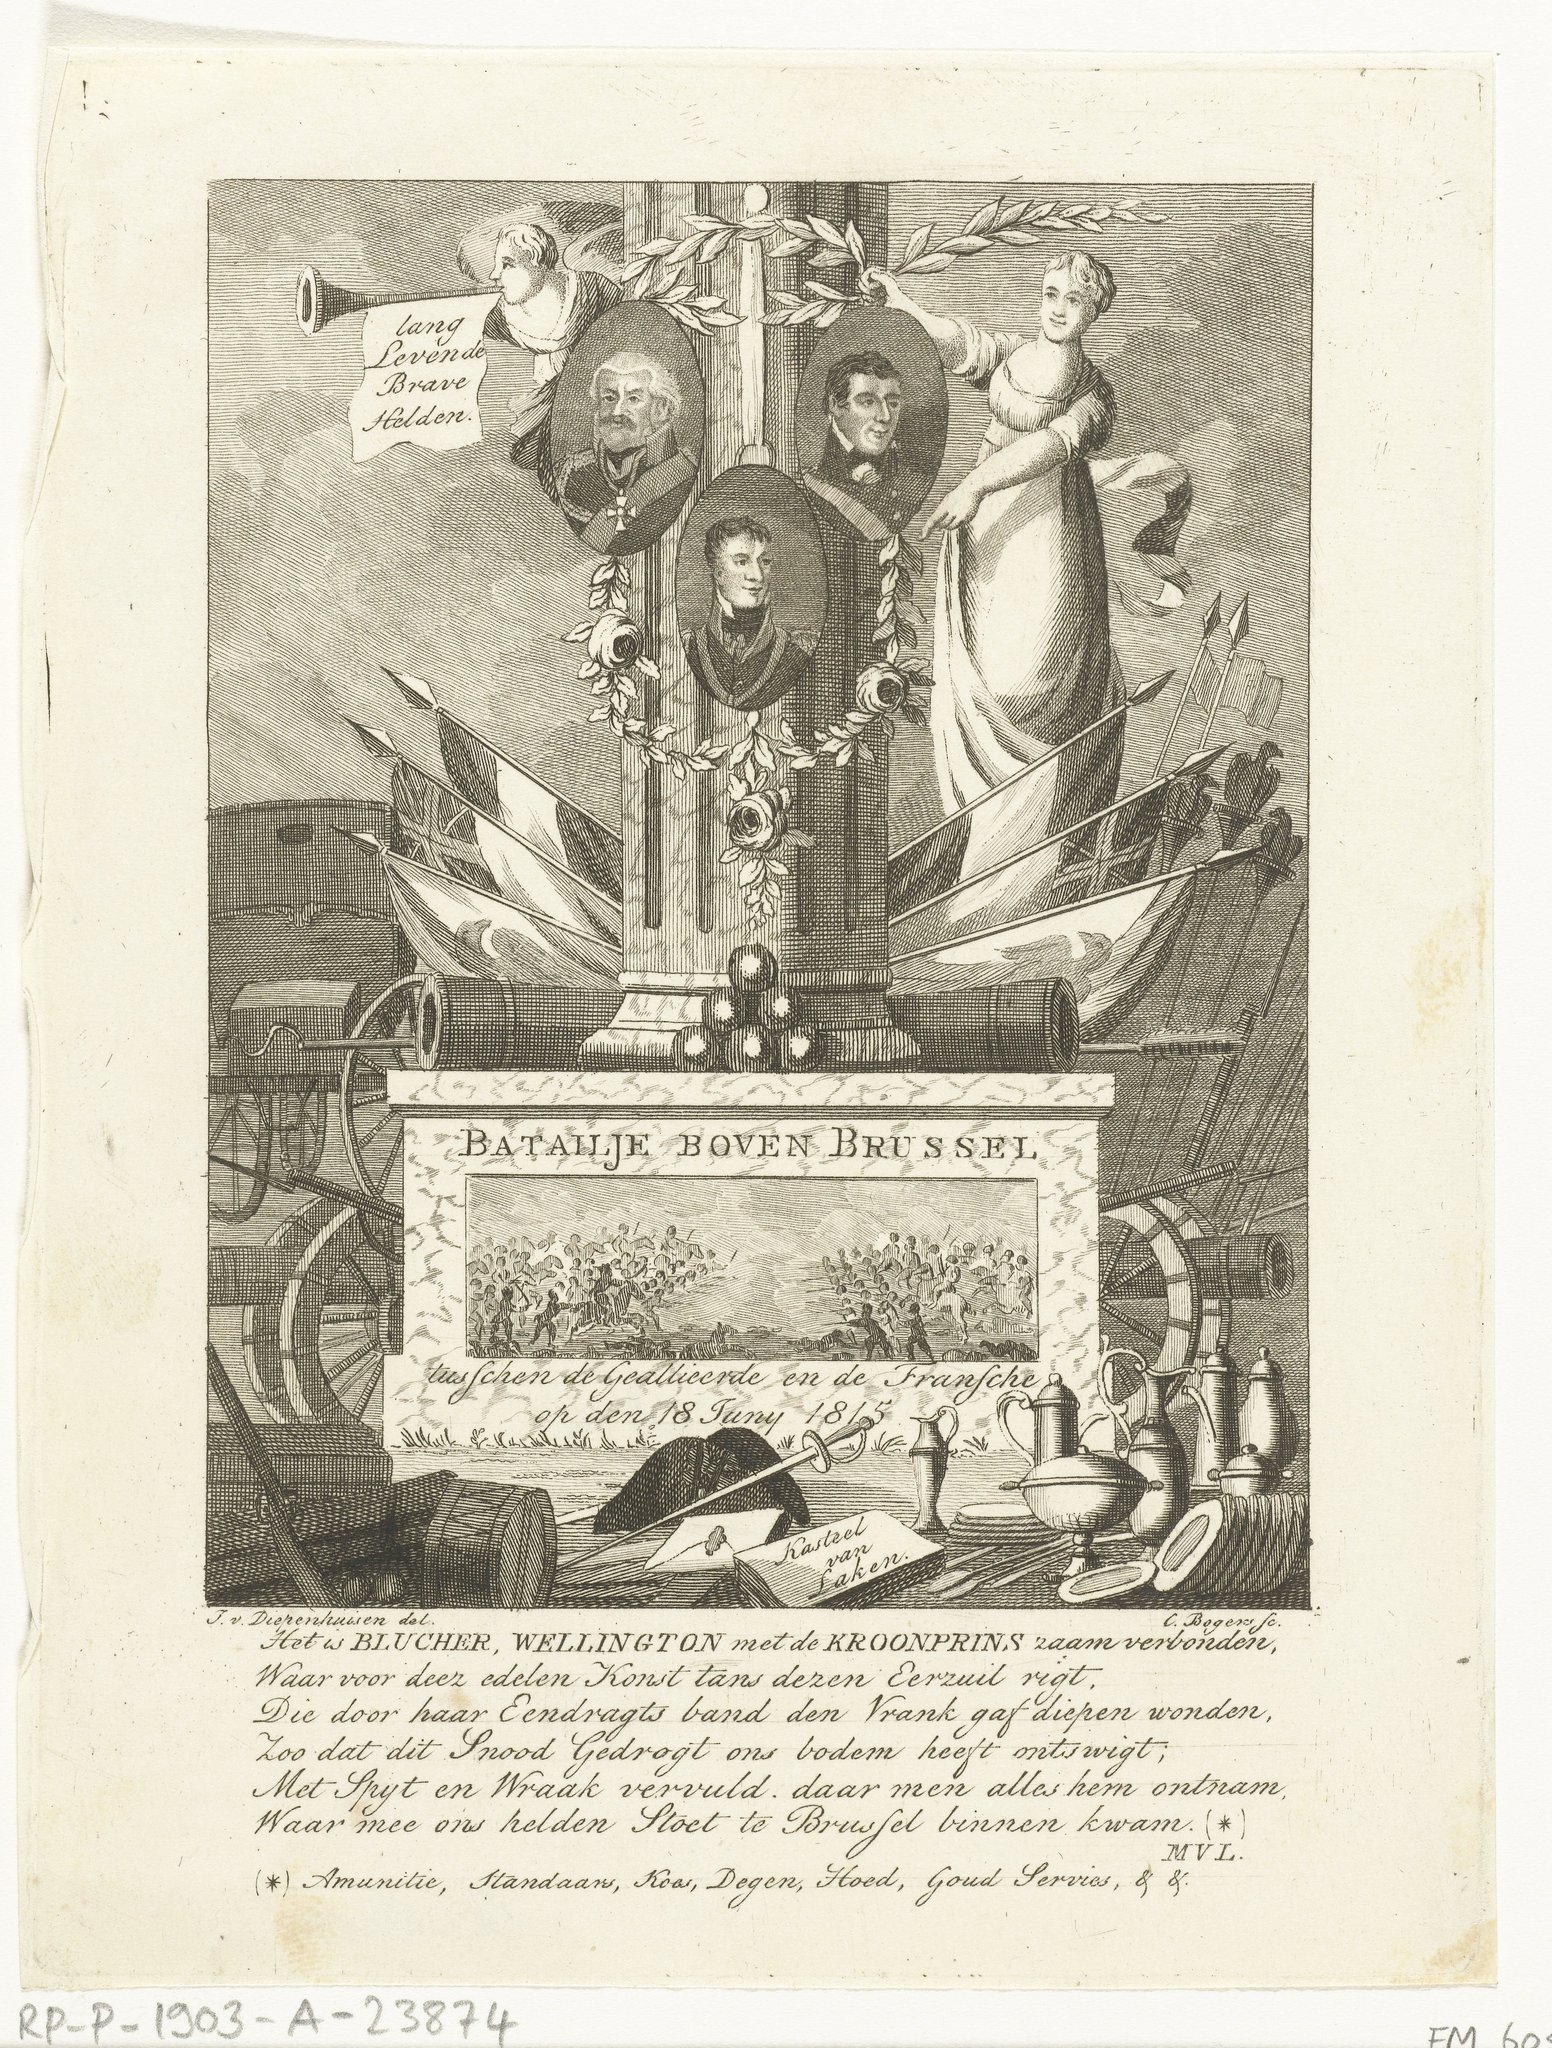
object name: print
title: Gedenkzuil voor de Slag bij Waterloo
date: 1815-1817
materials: paper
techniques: etching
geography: amsterdam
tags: the hague, william ii of the netherlands, walmer castle, arthur wellesley of wellington, monument, statue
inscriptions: collector's mark: Lugt 2228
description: Op het voetstuk een afbeelding van de Slag bij Waterloo, genoemd 'Batalje boven Brussel'. Aan de zuil hangen de portretten van Blücher, Wellington en de prins van Oranje, de latere Willem II. Een jonge vrouw smukt de zuil met bloemguirlandes. Achter de zuil zijn de vlaggen van de geallieerden gedrapeerd. Onder de voorstelling een Nederlands vers op de overwinning, getekend M.v.L.